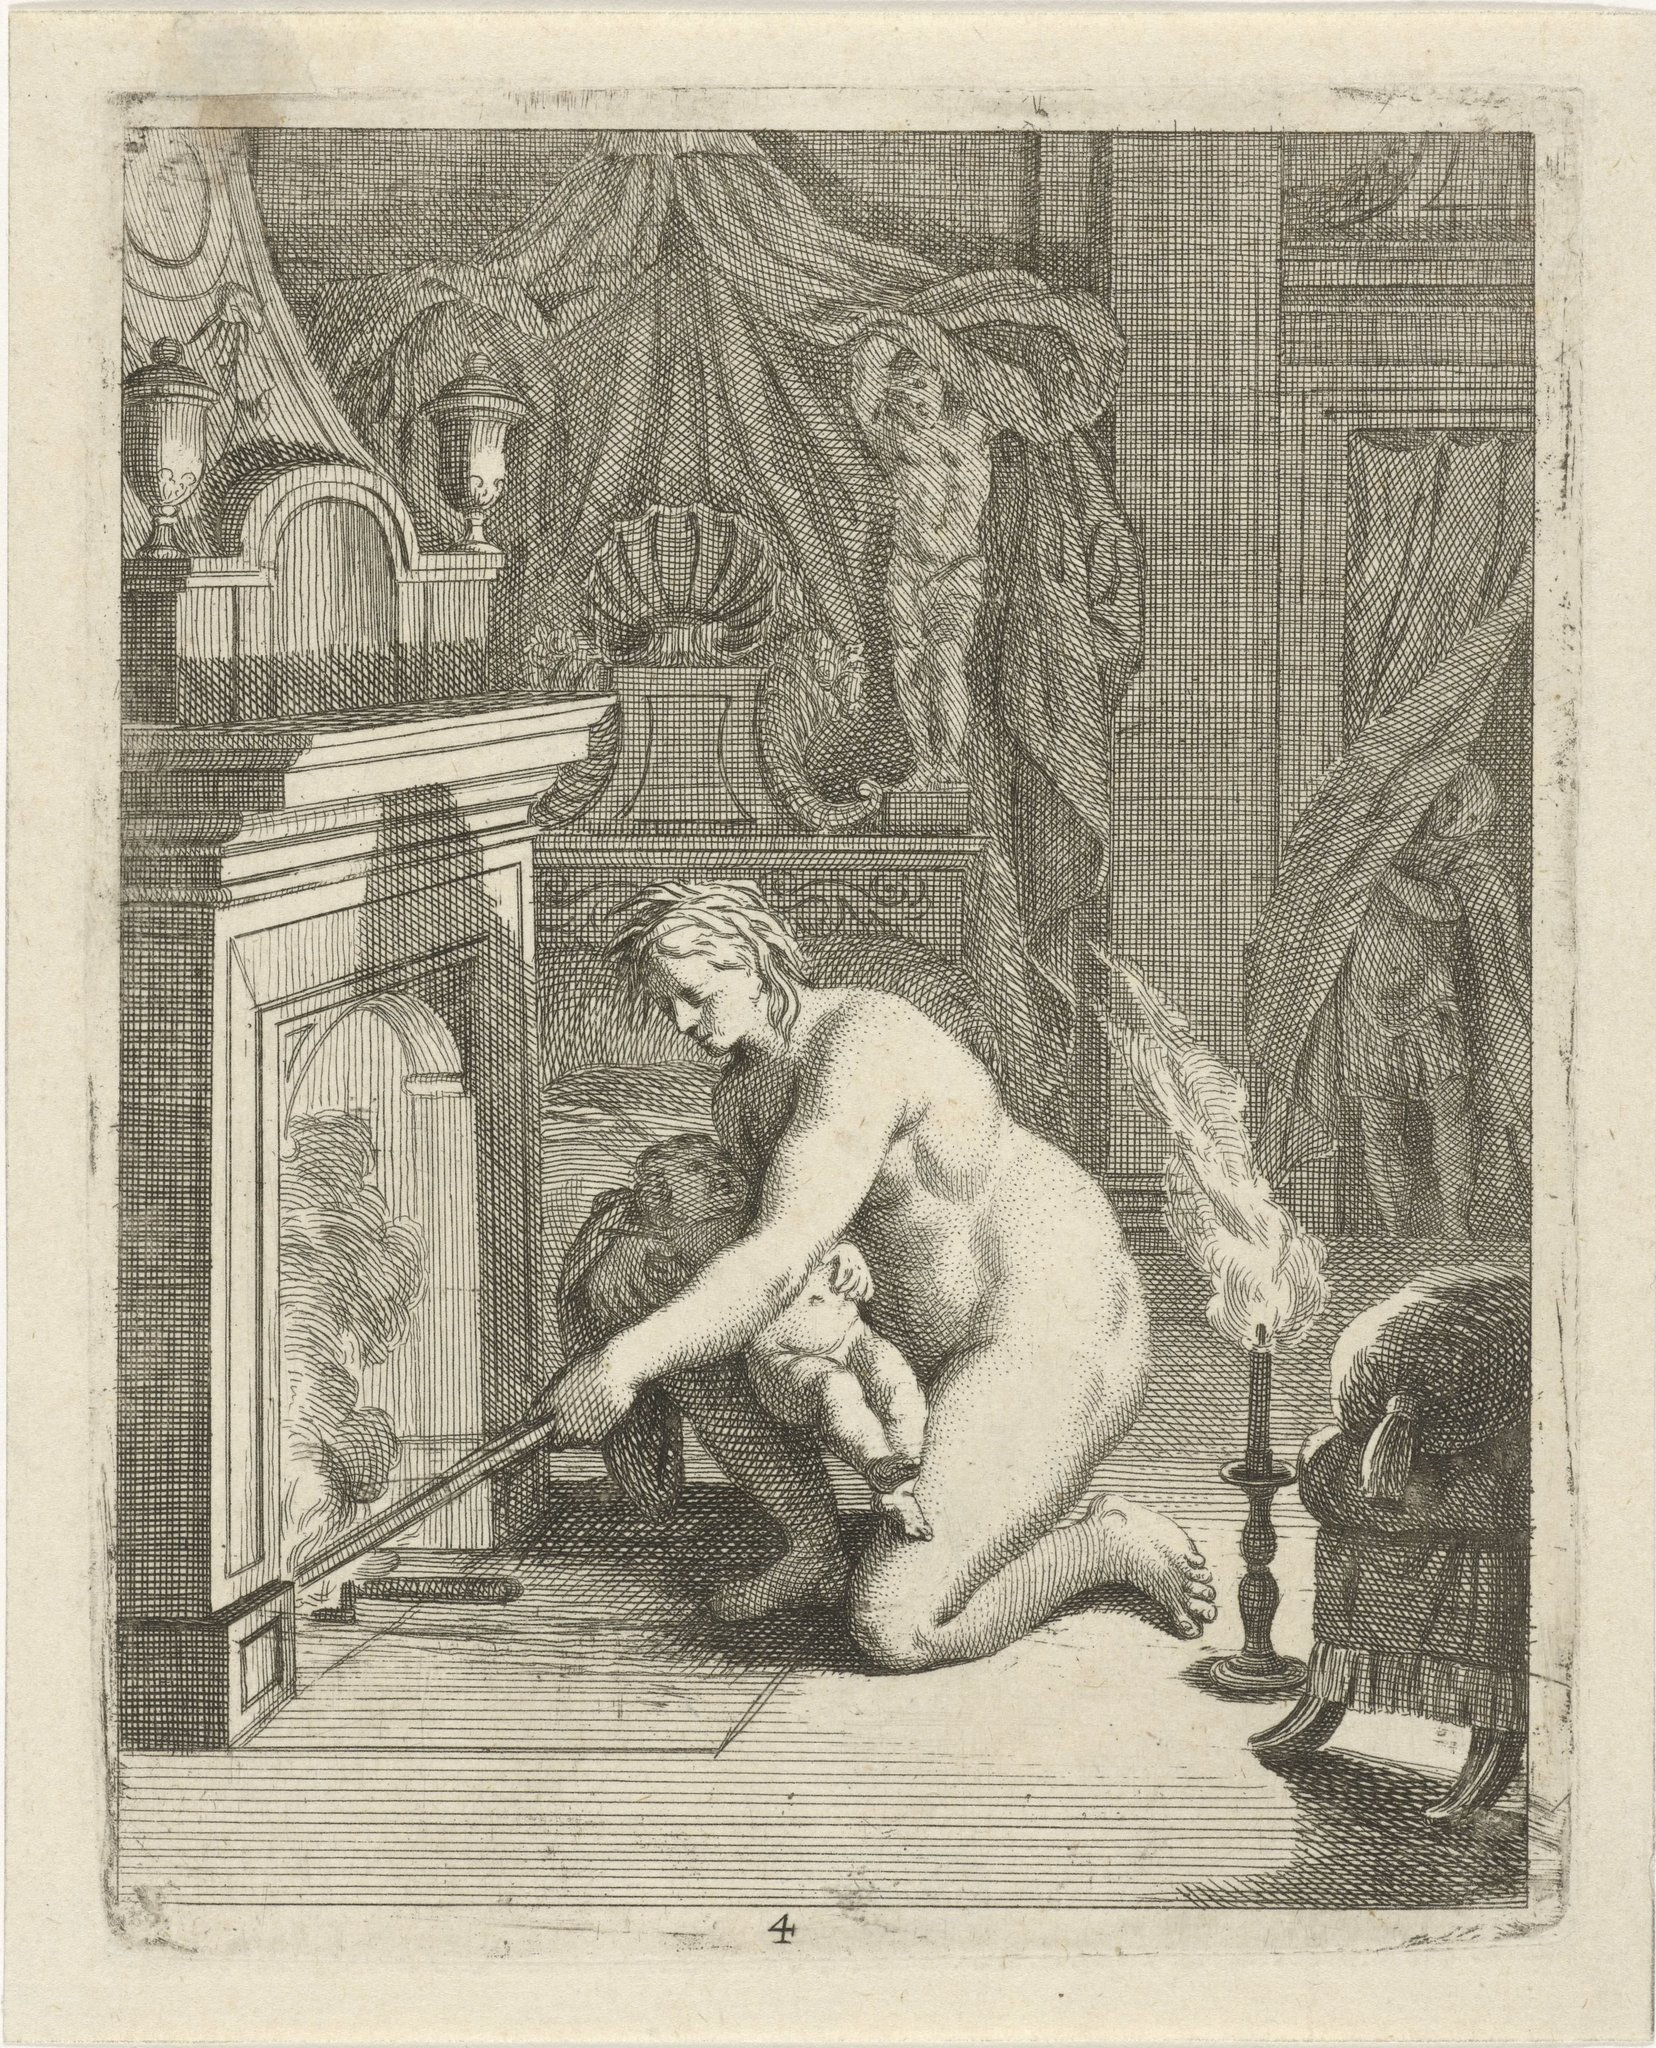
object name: print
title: Scènes uit het leven van Achilles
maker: j. alexander janssens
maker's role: print maker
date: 1700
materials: paper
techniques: engraving, etching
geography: southern netherlands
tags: thetis holds achilles in the fire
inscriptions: collector's mark: Lugt 2228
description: Interieur met een openhaard en een kandelaar met brandende kaars, bij nacht. Thetis zit gehurkt bij de openhaard en stookt het vuur op waar zij Achilles in wil houden om hem onsterfelijk te maken. Achilles leunt op haar knie. Rechts op de achtergrond kijkt Peleus toe. Midden onder: 4. Vierde prent uit een serie van veertien met scènes uit het leven van Achilles.